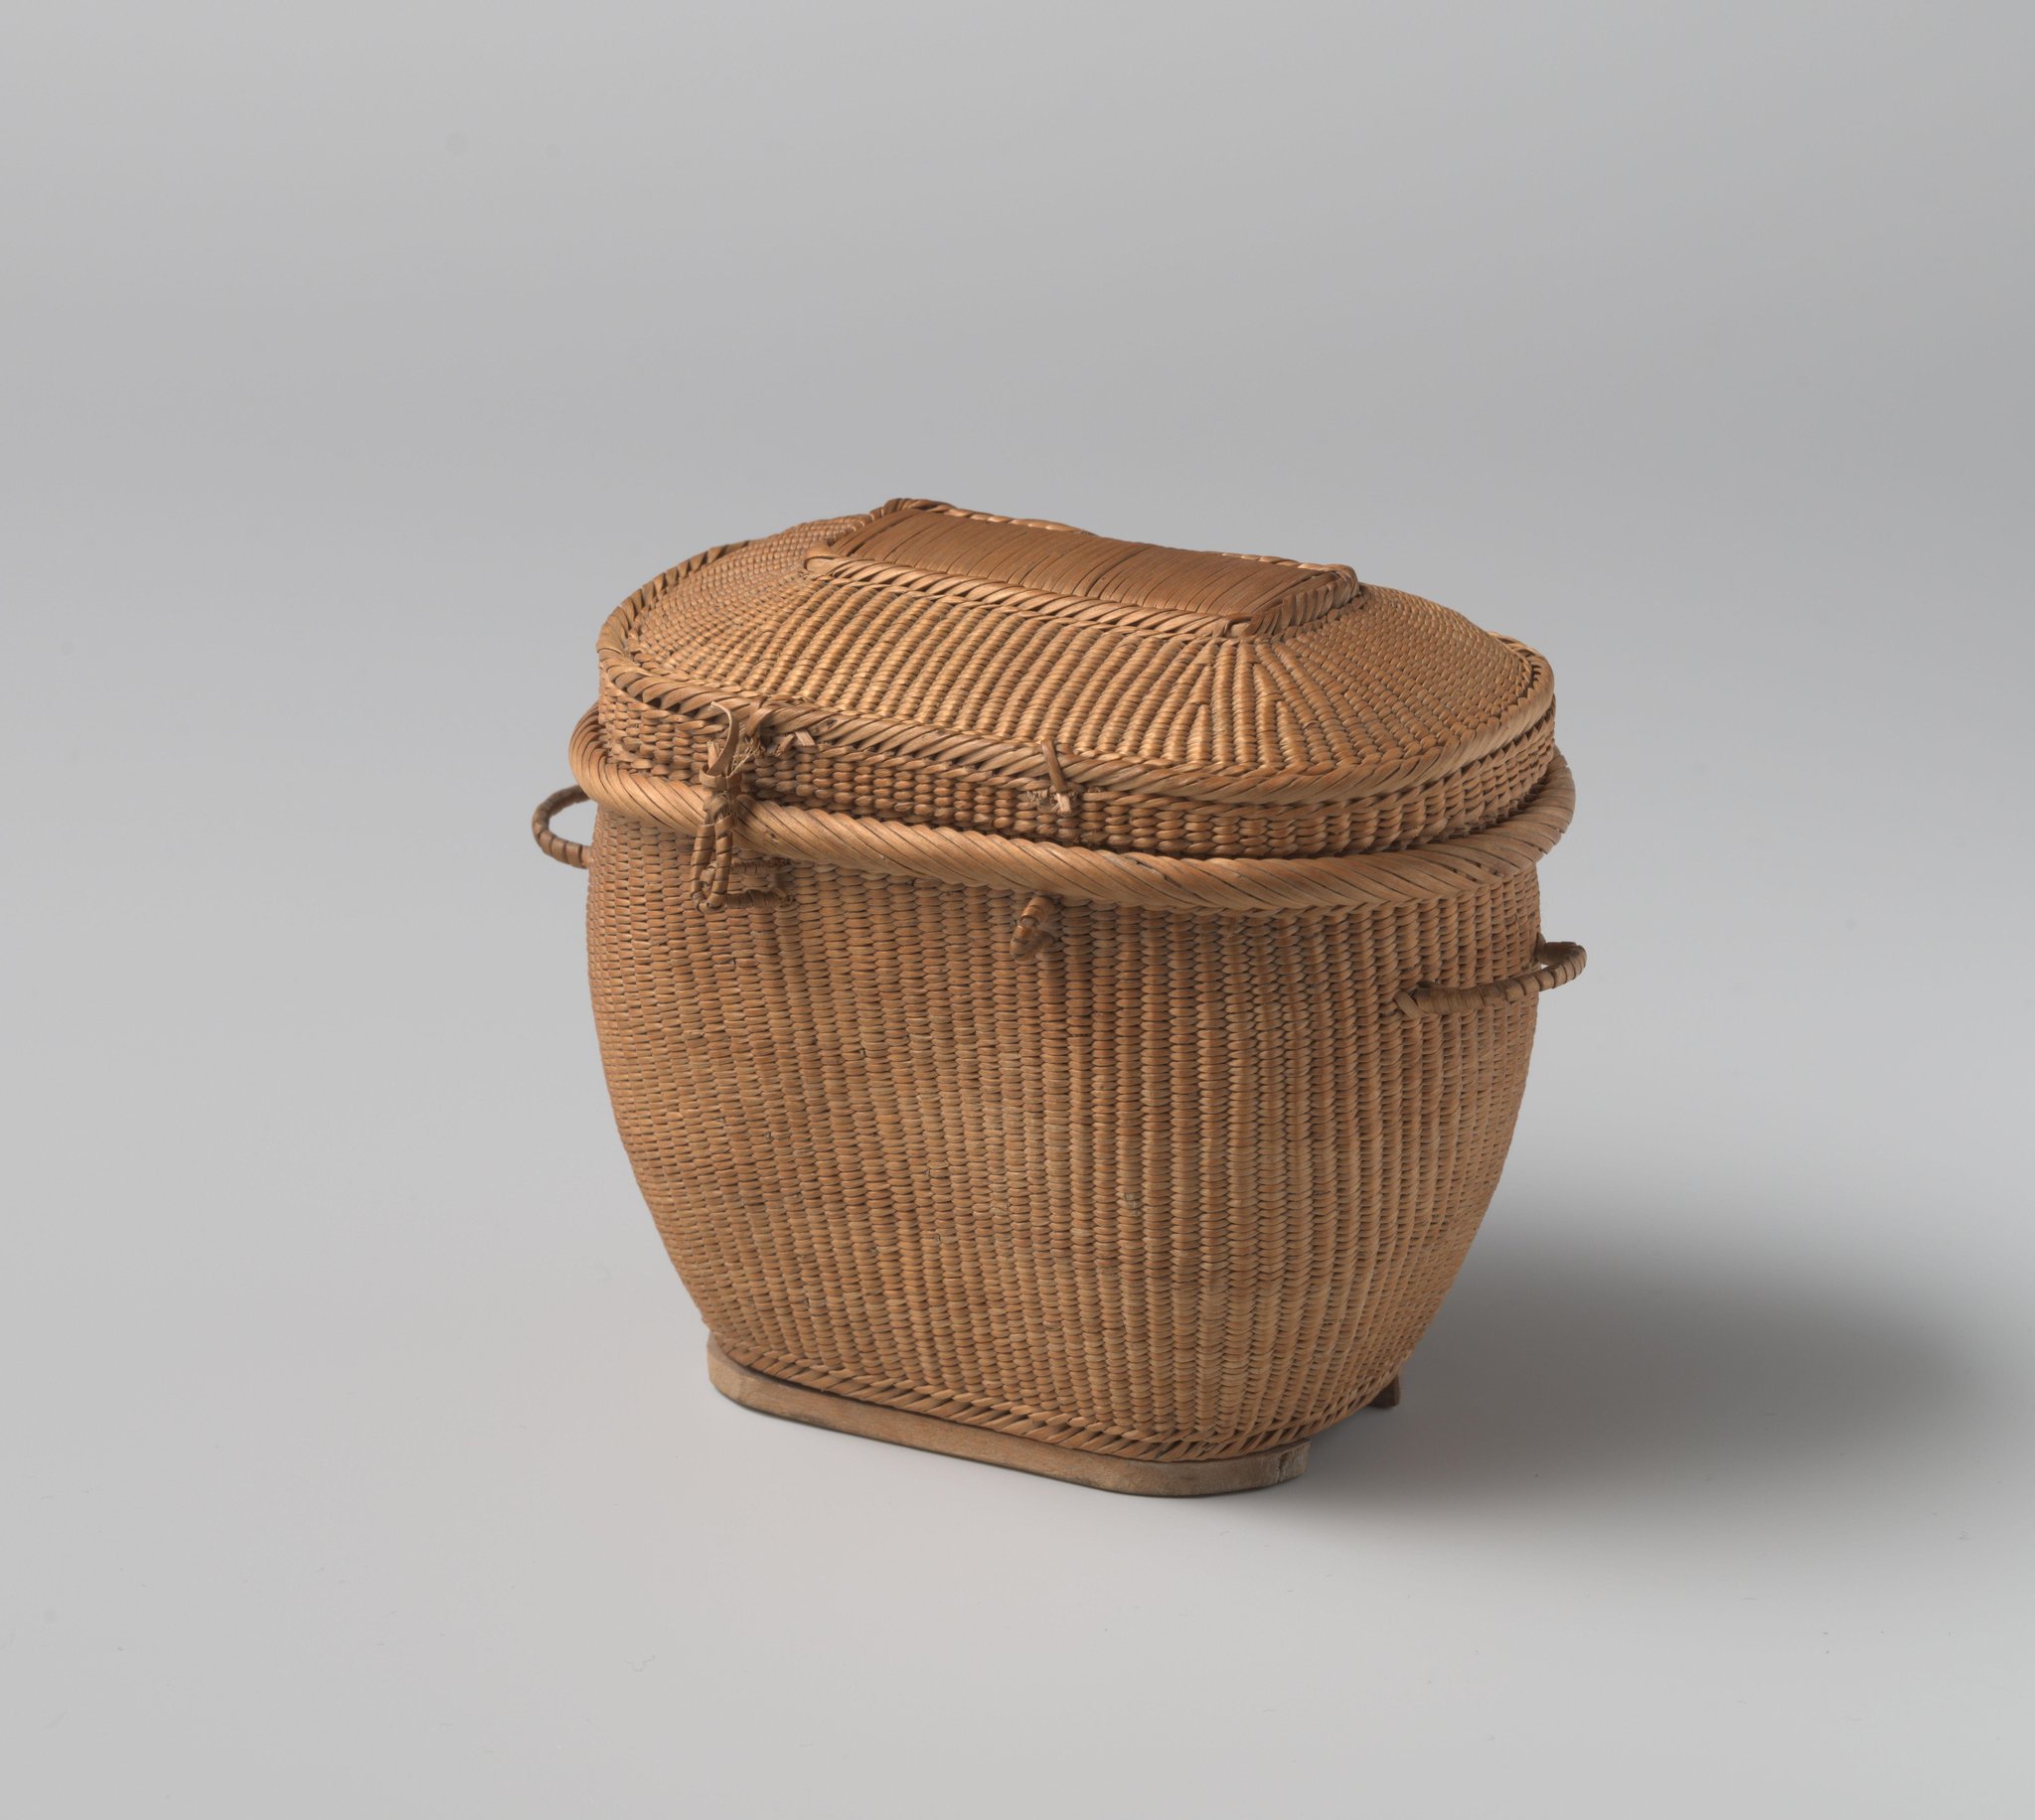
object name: basket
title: Ovale sluitmand van gespleten wilgenteen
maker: Anonymous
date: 1690-1710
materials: copper, wood, plant material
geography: halle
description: Ovale sluitmand van gespleten wilgenteen, fijnscheenwerk. Het deksel is bevestigd aan twee scharnieren van lussen, en is af te sluiten met twee lussen over een boog (deels verdwenen). Aan de zijkanten van de mand zitten twee handvatten. De mand is met van zes koperen spijkers met revetten op een houten slede bevestigd.